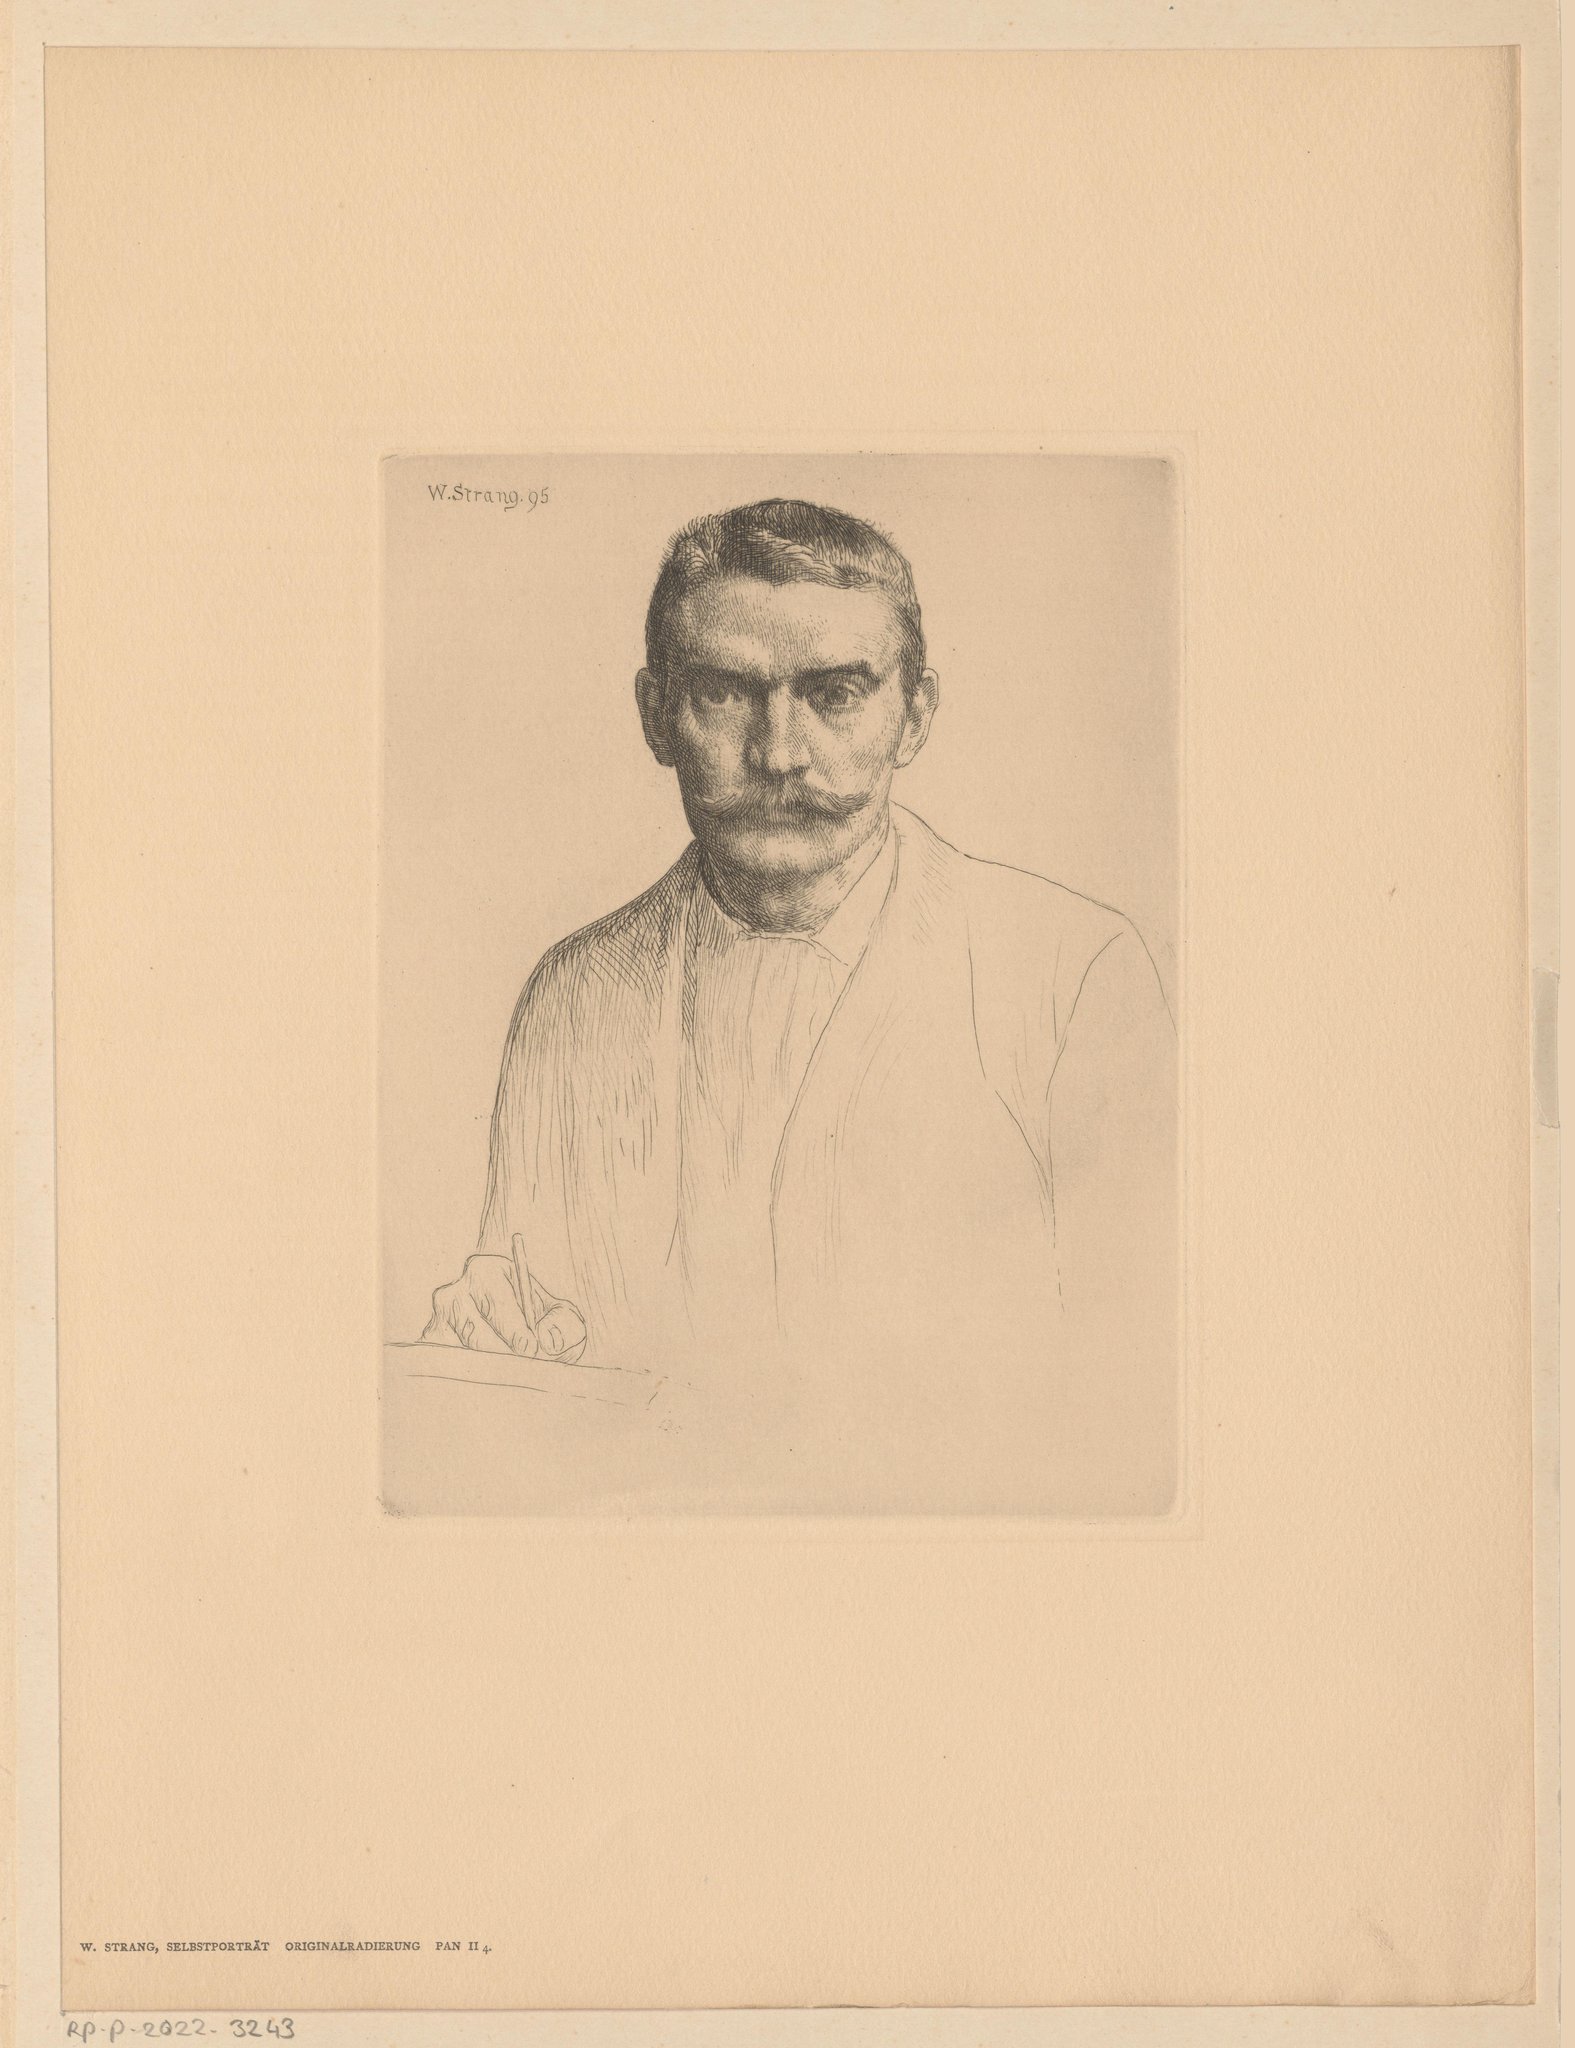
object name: print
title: Zelfportret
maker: william strang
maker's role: print maker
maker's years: 1859-1921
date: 1895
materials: paper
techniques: drypoint, etching, intaglio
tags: william strang, portrait, self-portrait of graphic artist (+ artist at work), historical persons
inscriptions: collector's mark: Lugt 2228, inscription: ‘W. Strang, Selbstporträt Originalradierung pan II 4.’